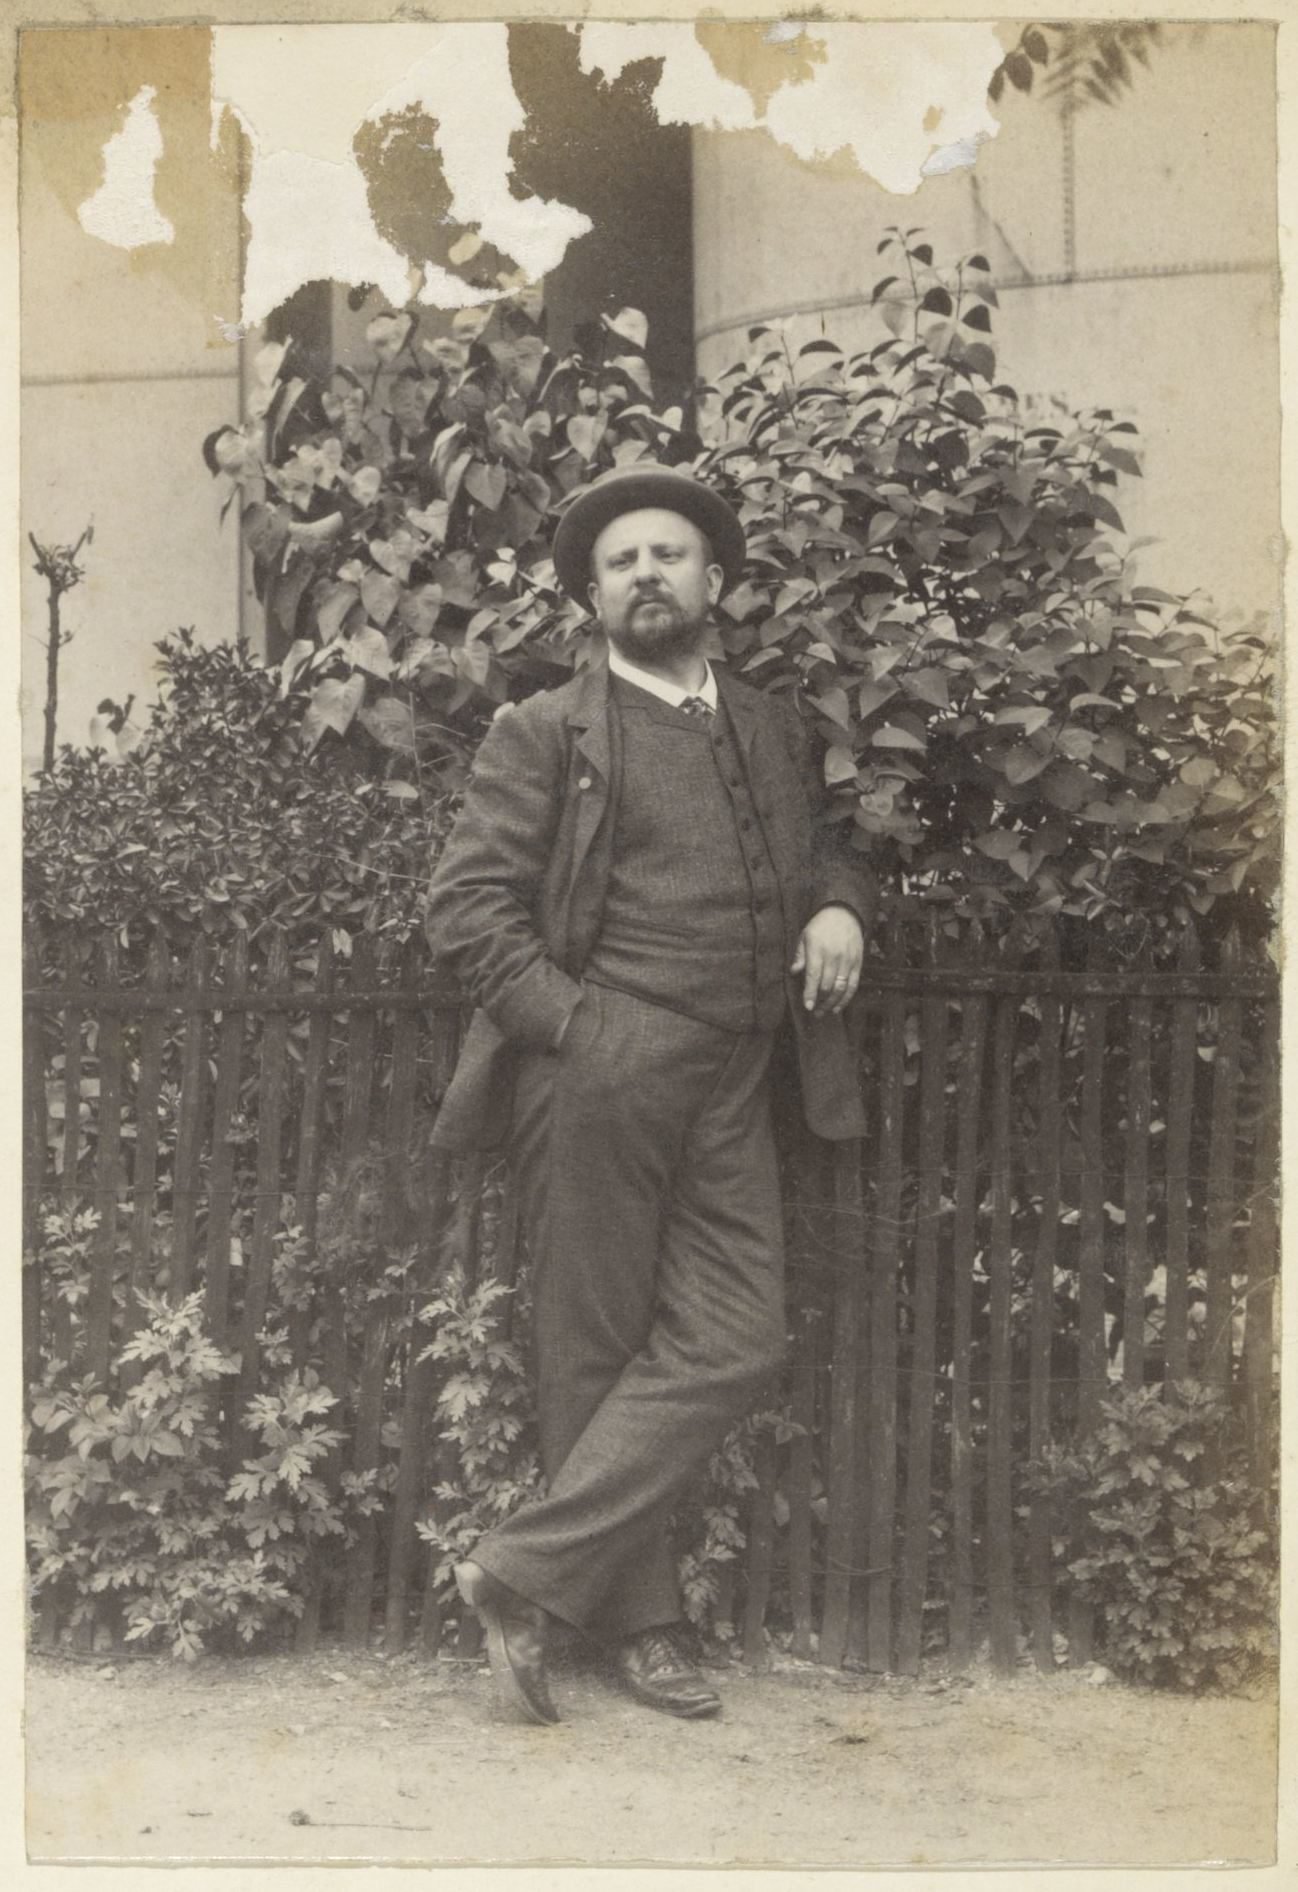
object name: photograph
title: Portret van een man staand bij een hek in Frankrijk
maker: Anonymous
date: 1900-1910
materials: paper, photographic support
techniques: albumen print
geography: france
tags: hand in the pocket, fence, wall, paling, adult man, france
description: Onderdeel van Fotoalbum van een Franse amateurfotograaf met opnames van een familie, distilleerderij Delizy & Doistau Fils, het leger en bezienswaardigheden in Frankrijk.